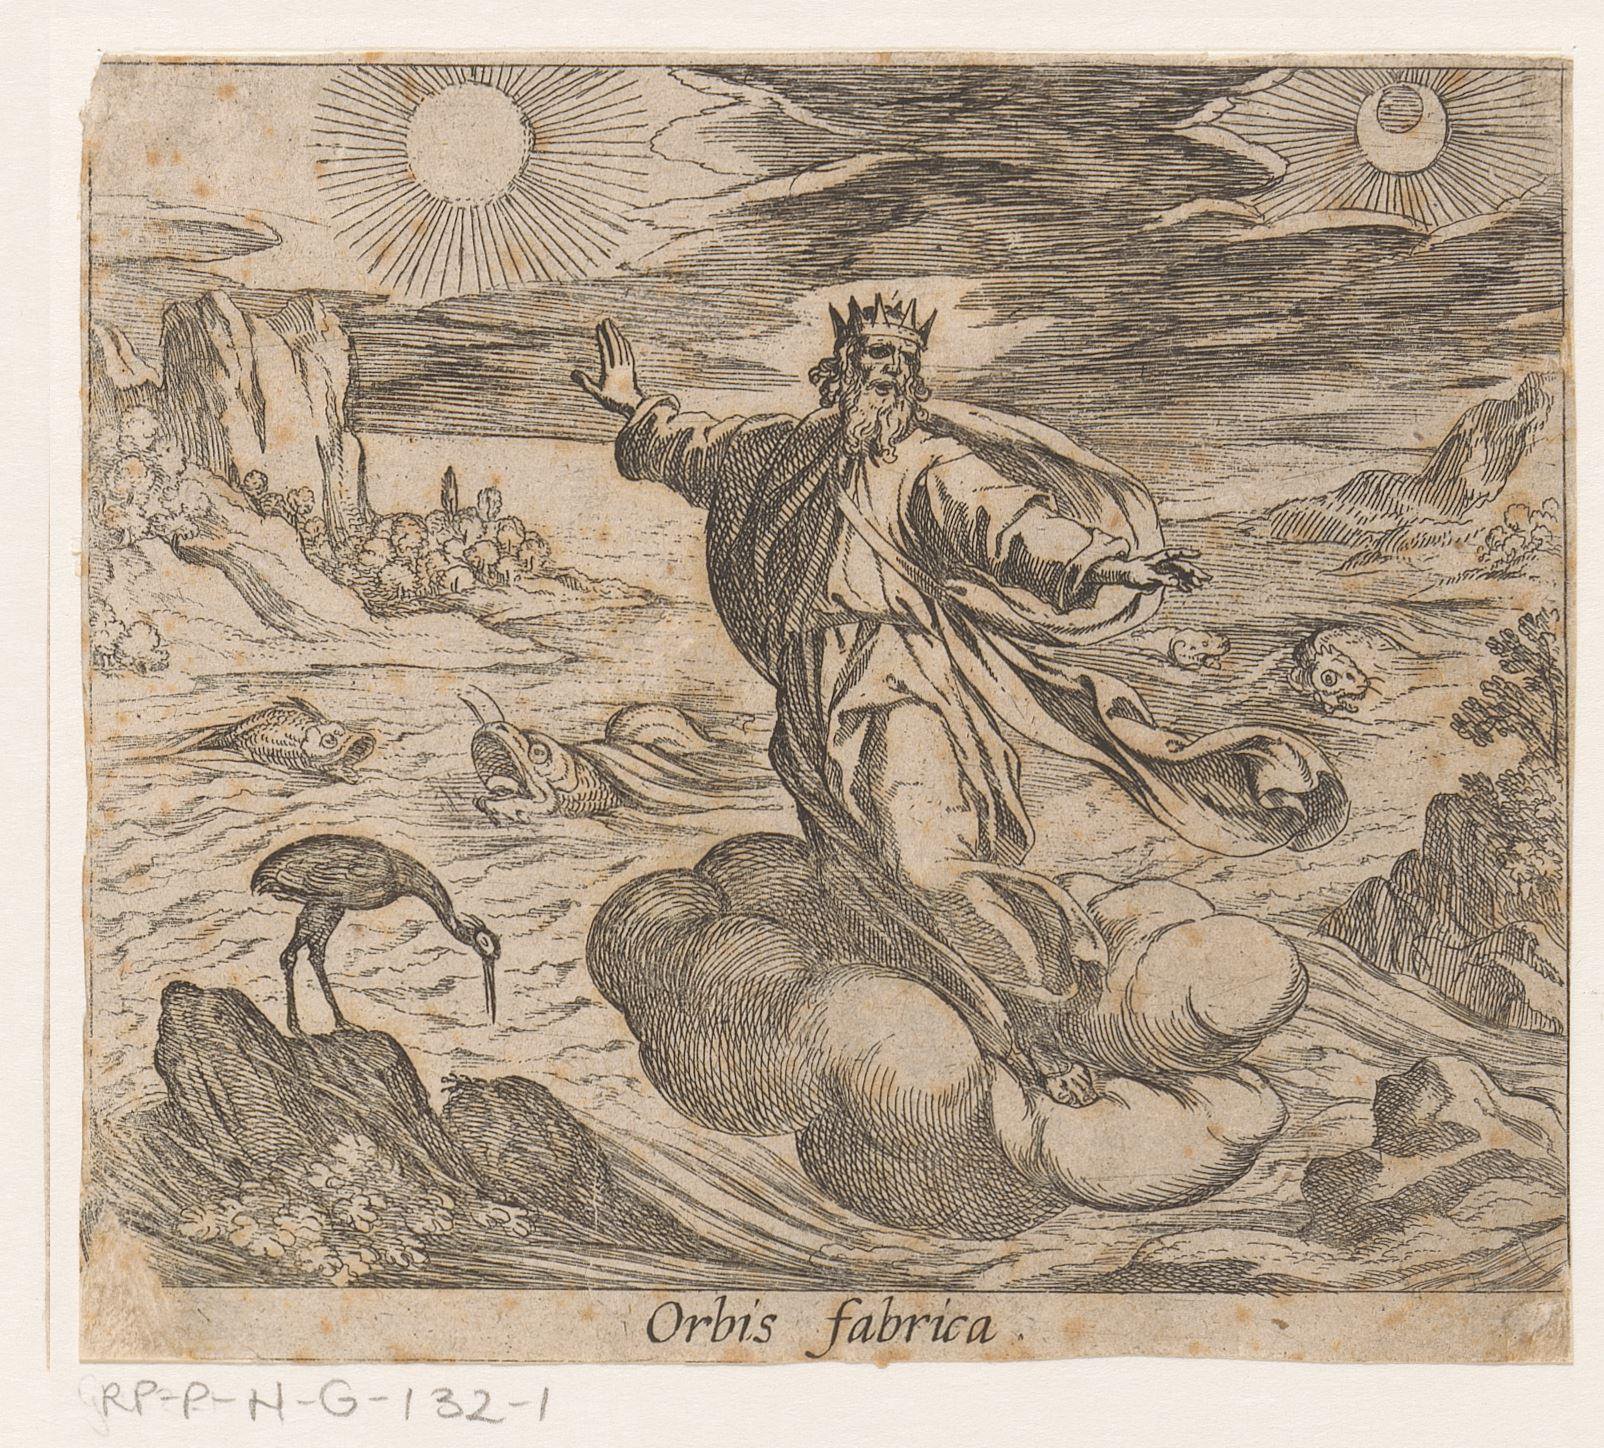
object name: print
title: Dochters van Pelias doden hun vader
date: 1606-1638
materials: paper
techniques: etching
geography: italy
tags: the daughters of pelias kill their father in his bed; medea plunges his body in boiling water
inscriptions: collector's mark: ‘Hinloopen’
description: Medea, door de lucht rijdend op haar rijtuig, dwingt de dochters van de slapende Pelias hun vader te vermoorden. Titel in het Latijn in ondermarge.